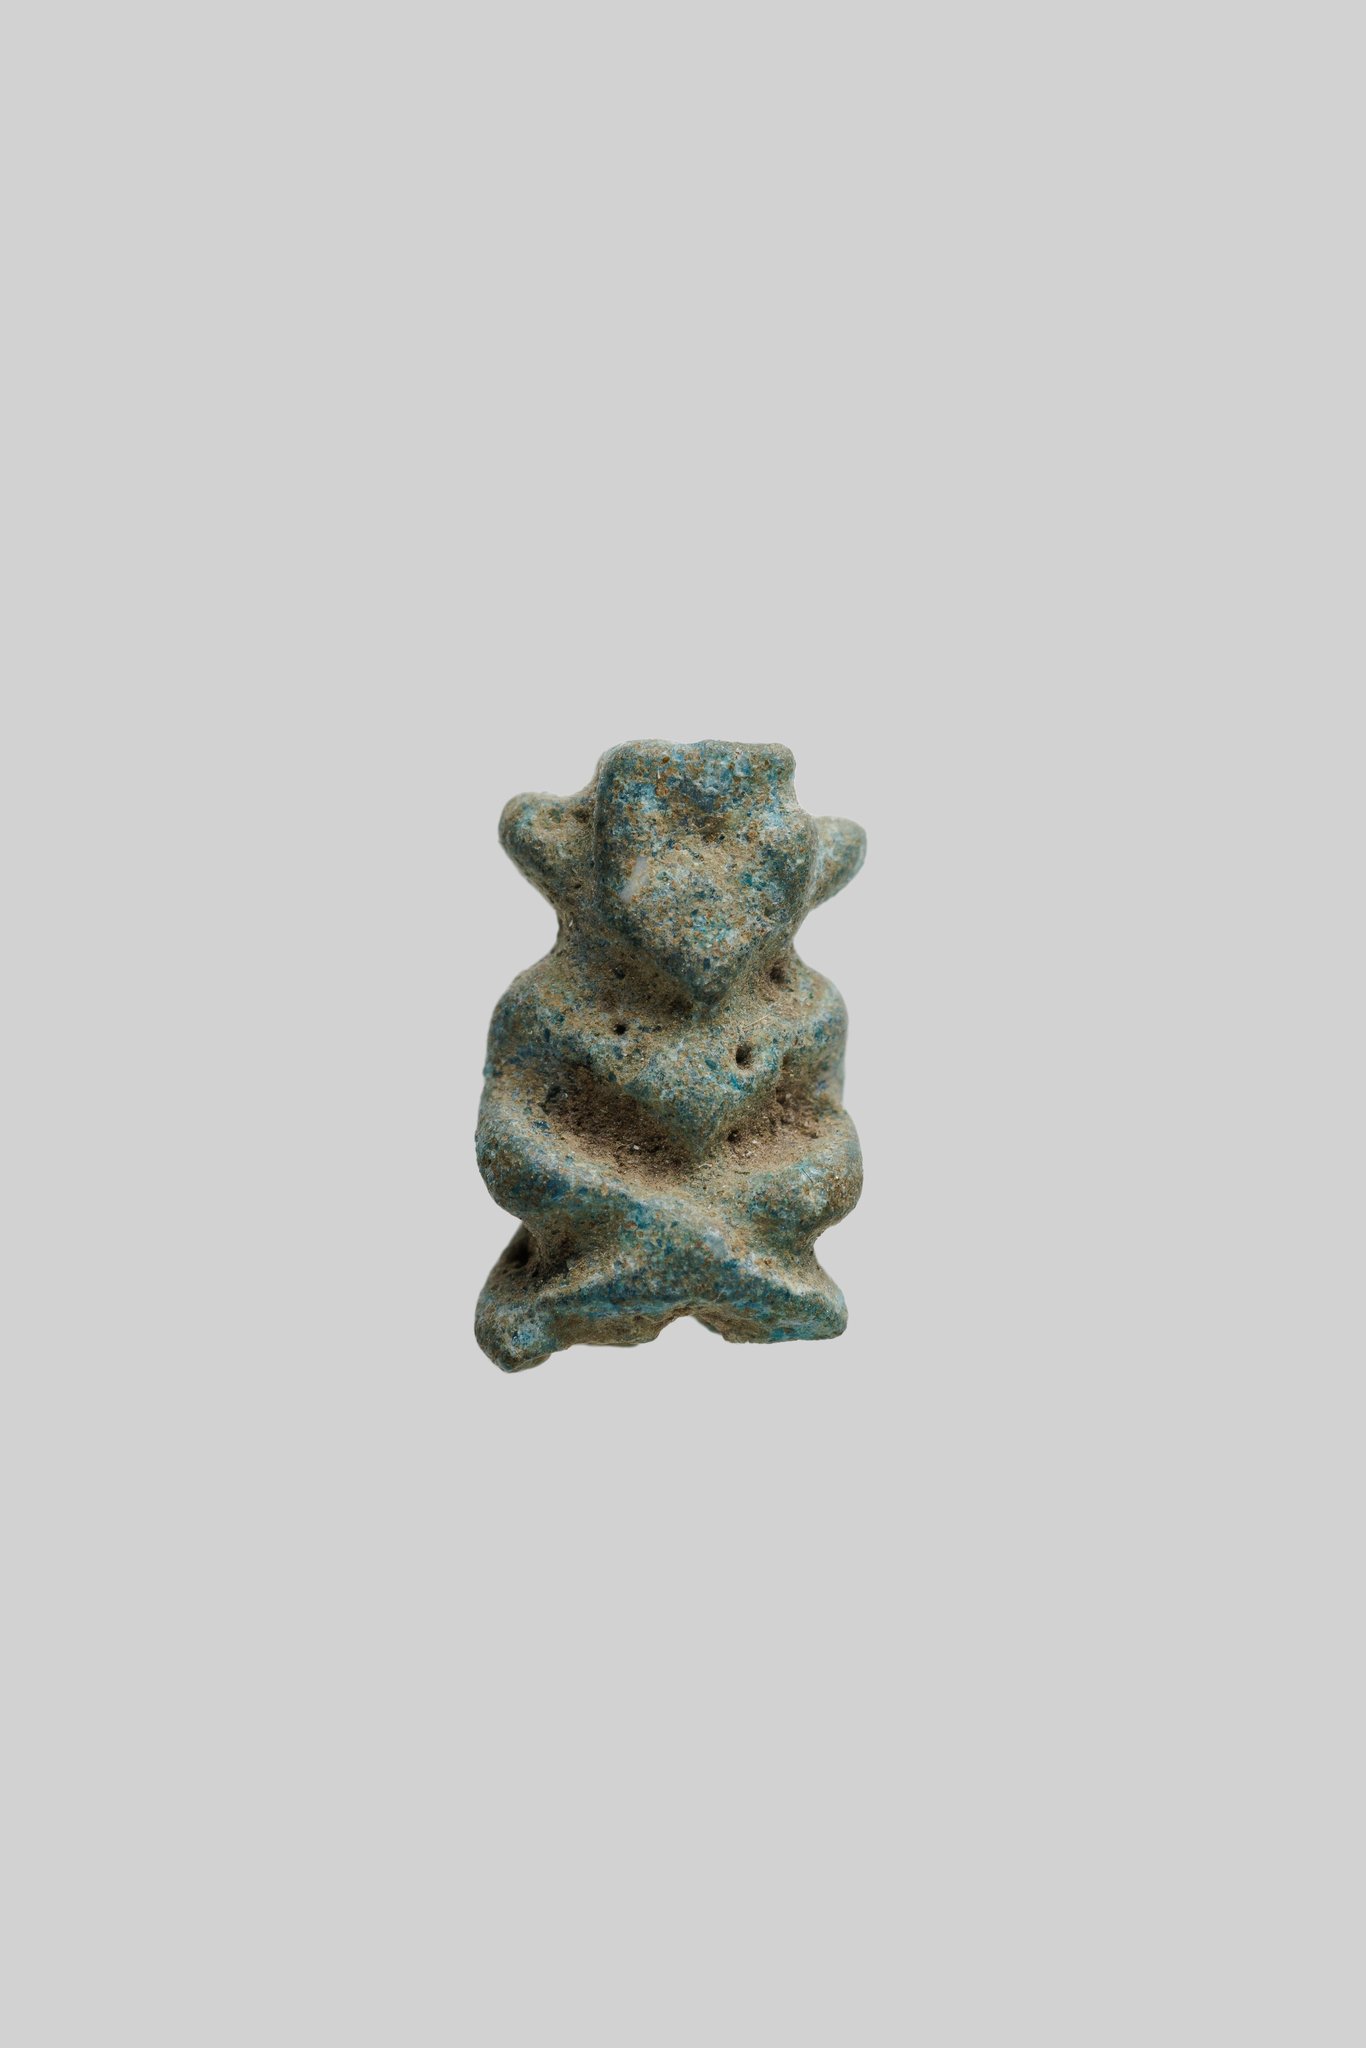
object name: amulet, be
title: Bes amulet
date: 1295-1070 BCE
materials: faience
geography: egypt